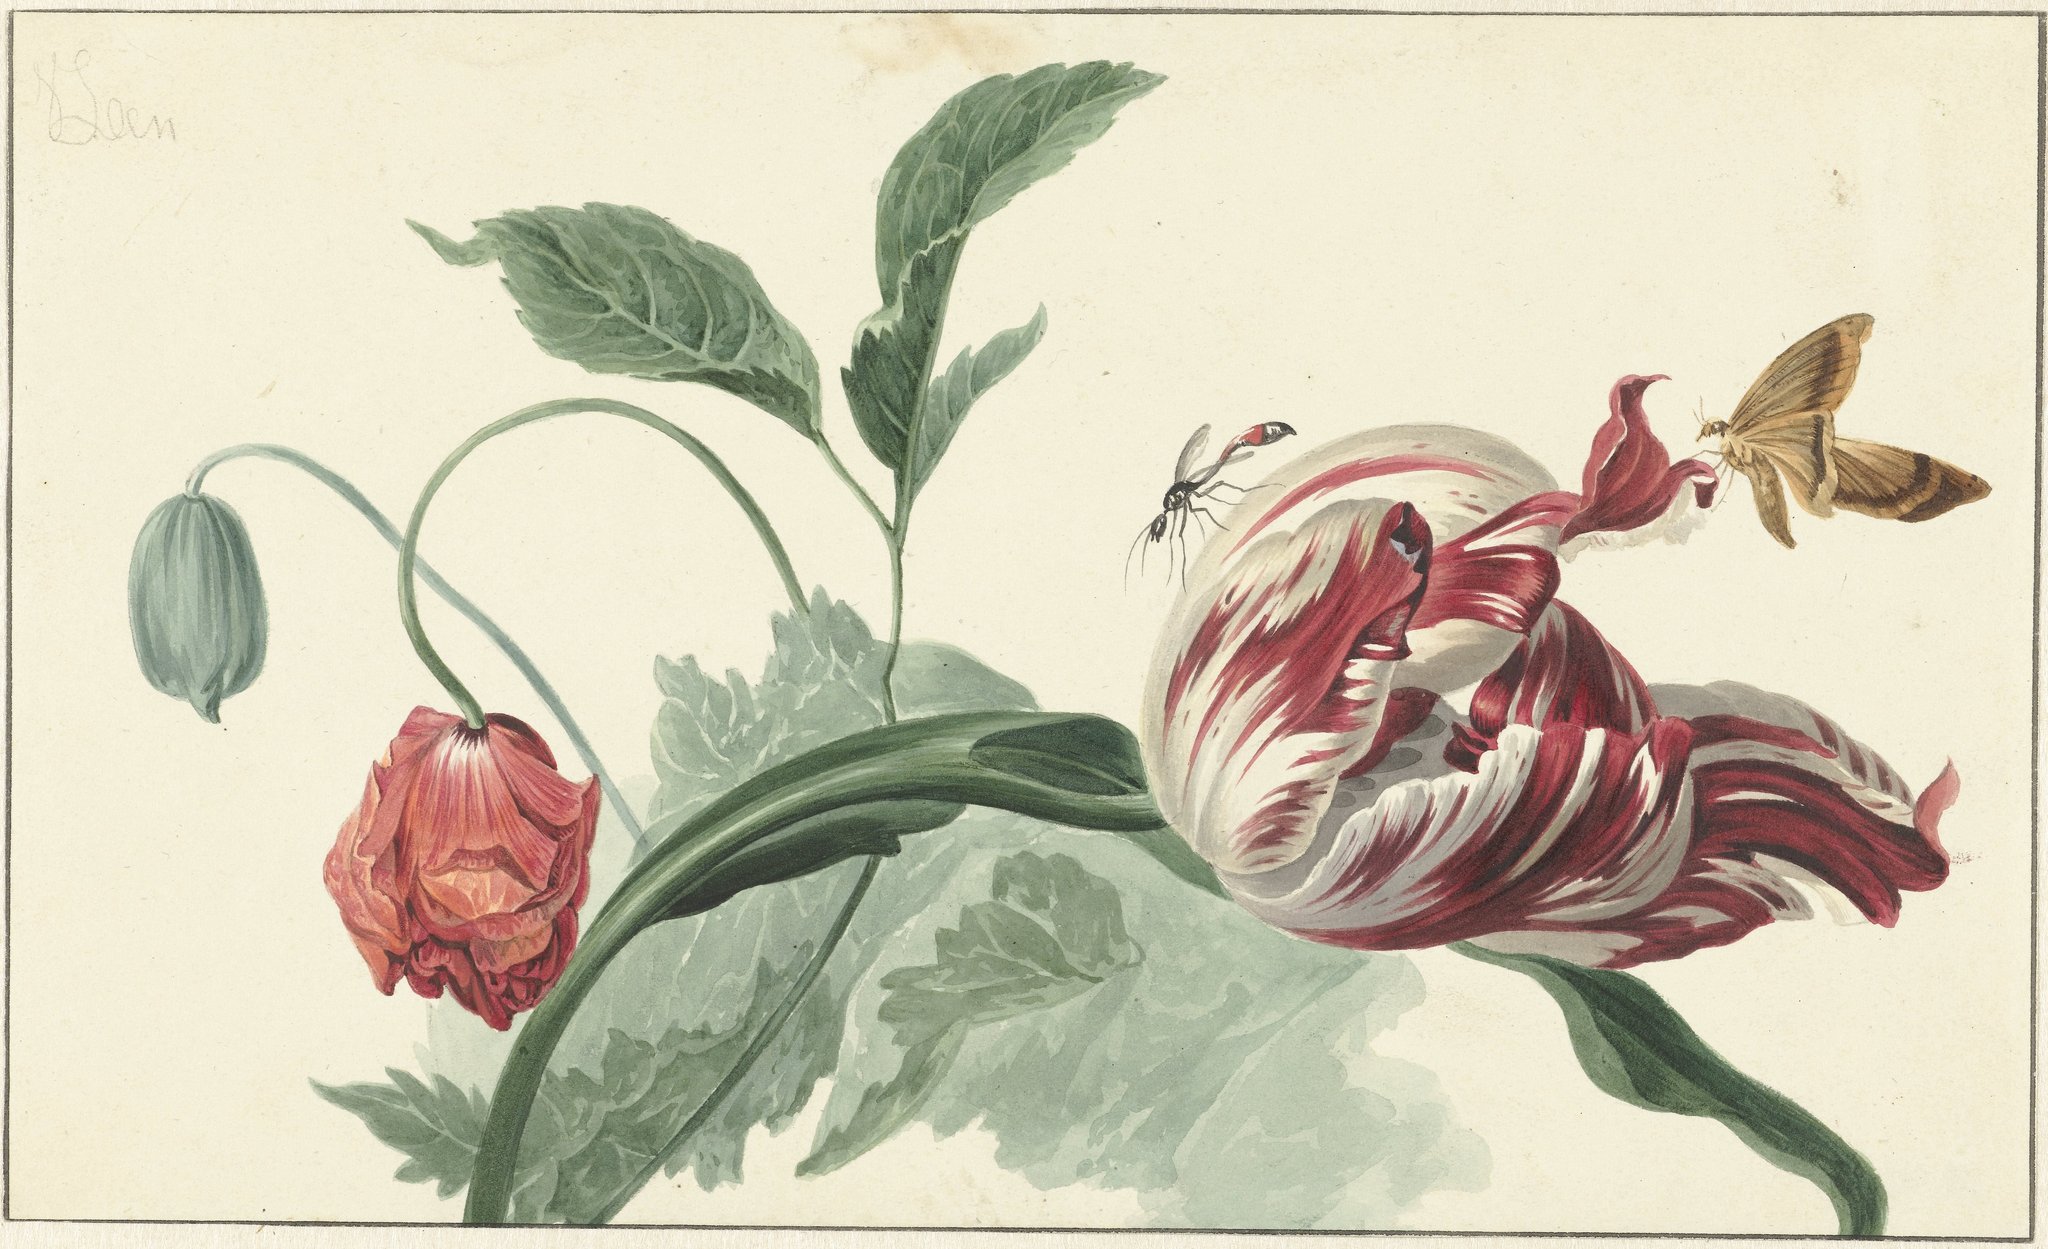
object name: watercolor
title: Tulip and a Poppy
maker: willem van leen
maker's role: draughtsman, print maker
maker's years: 1753-1825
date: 1763-1825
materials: paper, watercolor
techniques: brush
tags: flowers: tulip, flowers: poppy